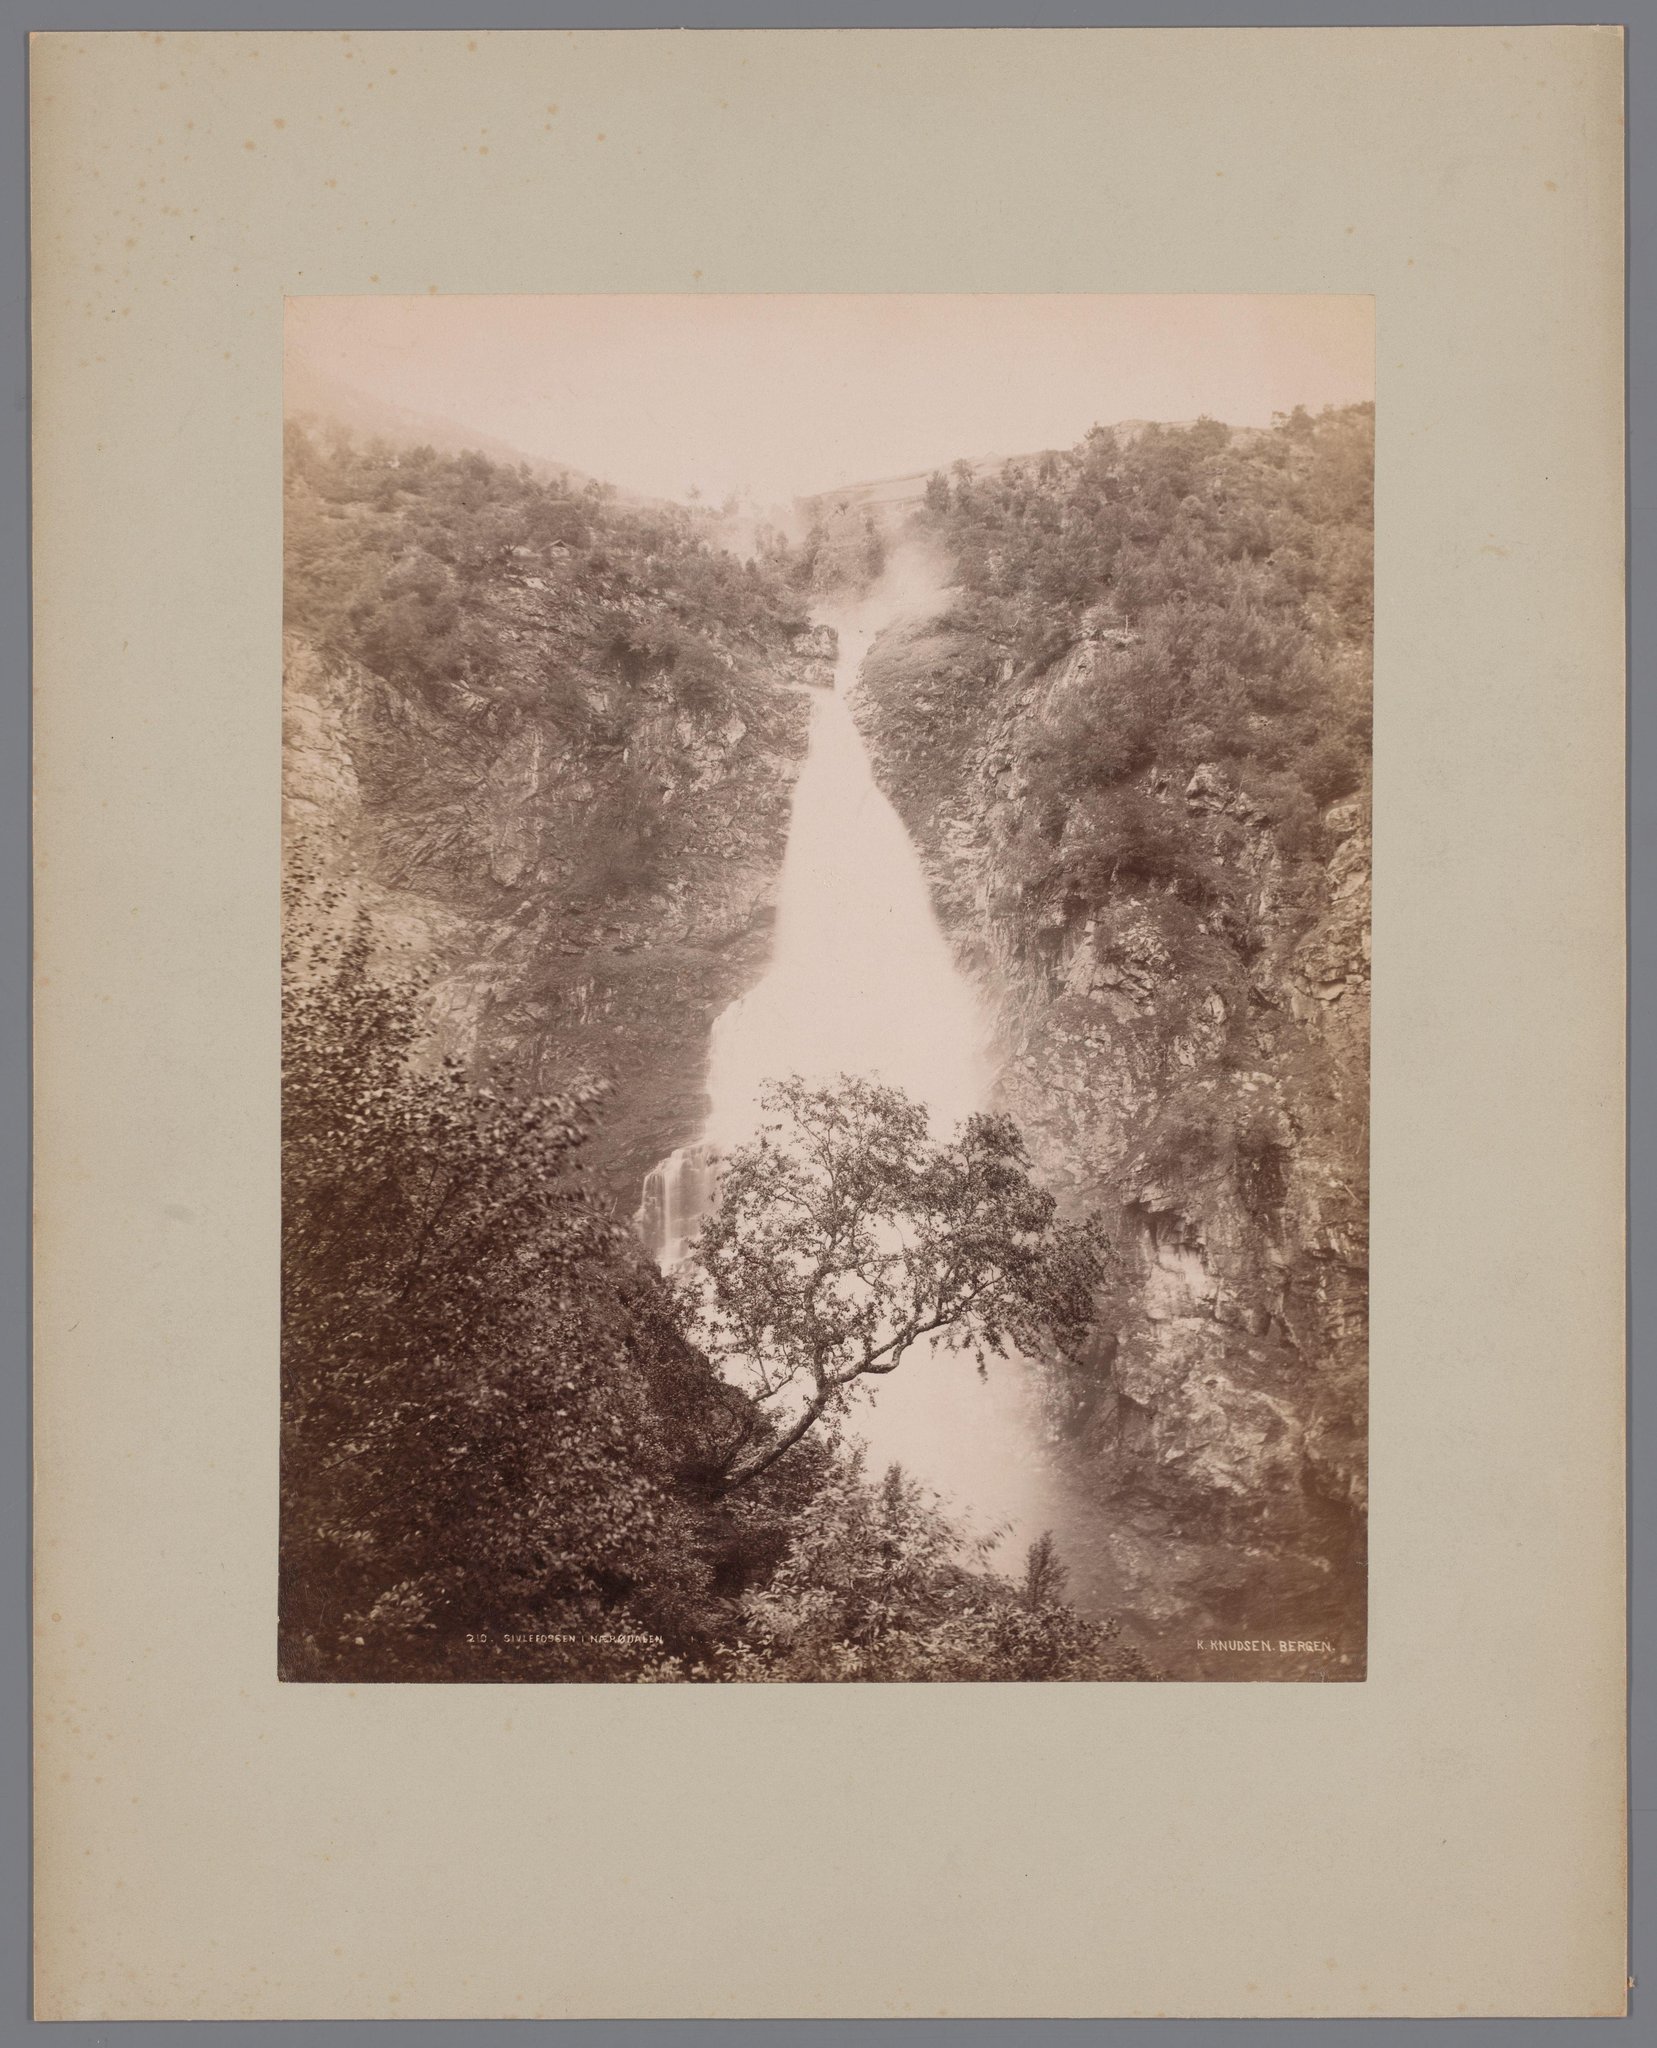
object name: photograph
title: Sivlefossen i Nærødalen, Noorwegen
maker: knud knudsen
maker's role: fotograaf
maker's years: 1832-1915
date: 1870-1900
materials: cardboard, photographic support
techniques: albumen print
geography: norway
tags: norway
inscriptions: caption: ‘210. SIVLEFOSSEN I NÆRØDALEN’, number: ‘K. KNUDSEN, BERGEN.’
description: Frontaal aanzicht op een hoge waterval Sivlefossen, bij een steile haarspeldweg, genaamd Stalheimskleiva, bij Stalheim (op de route tussen Oslo en Bergen), Noorwegen.